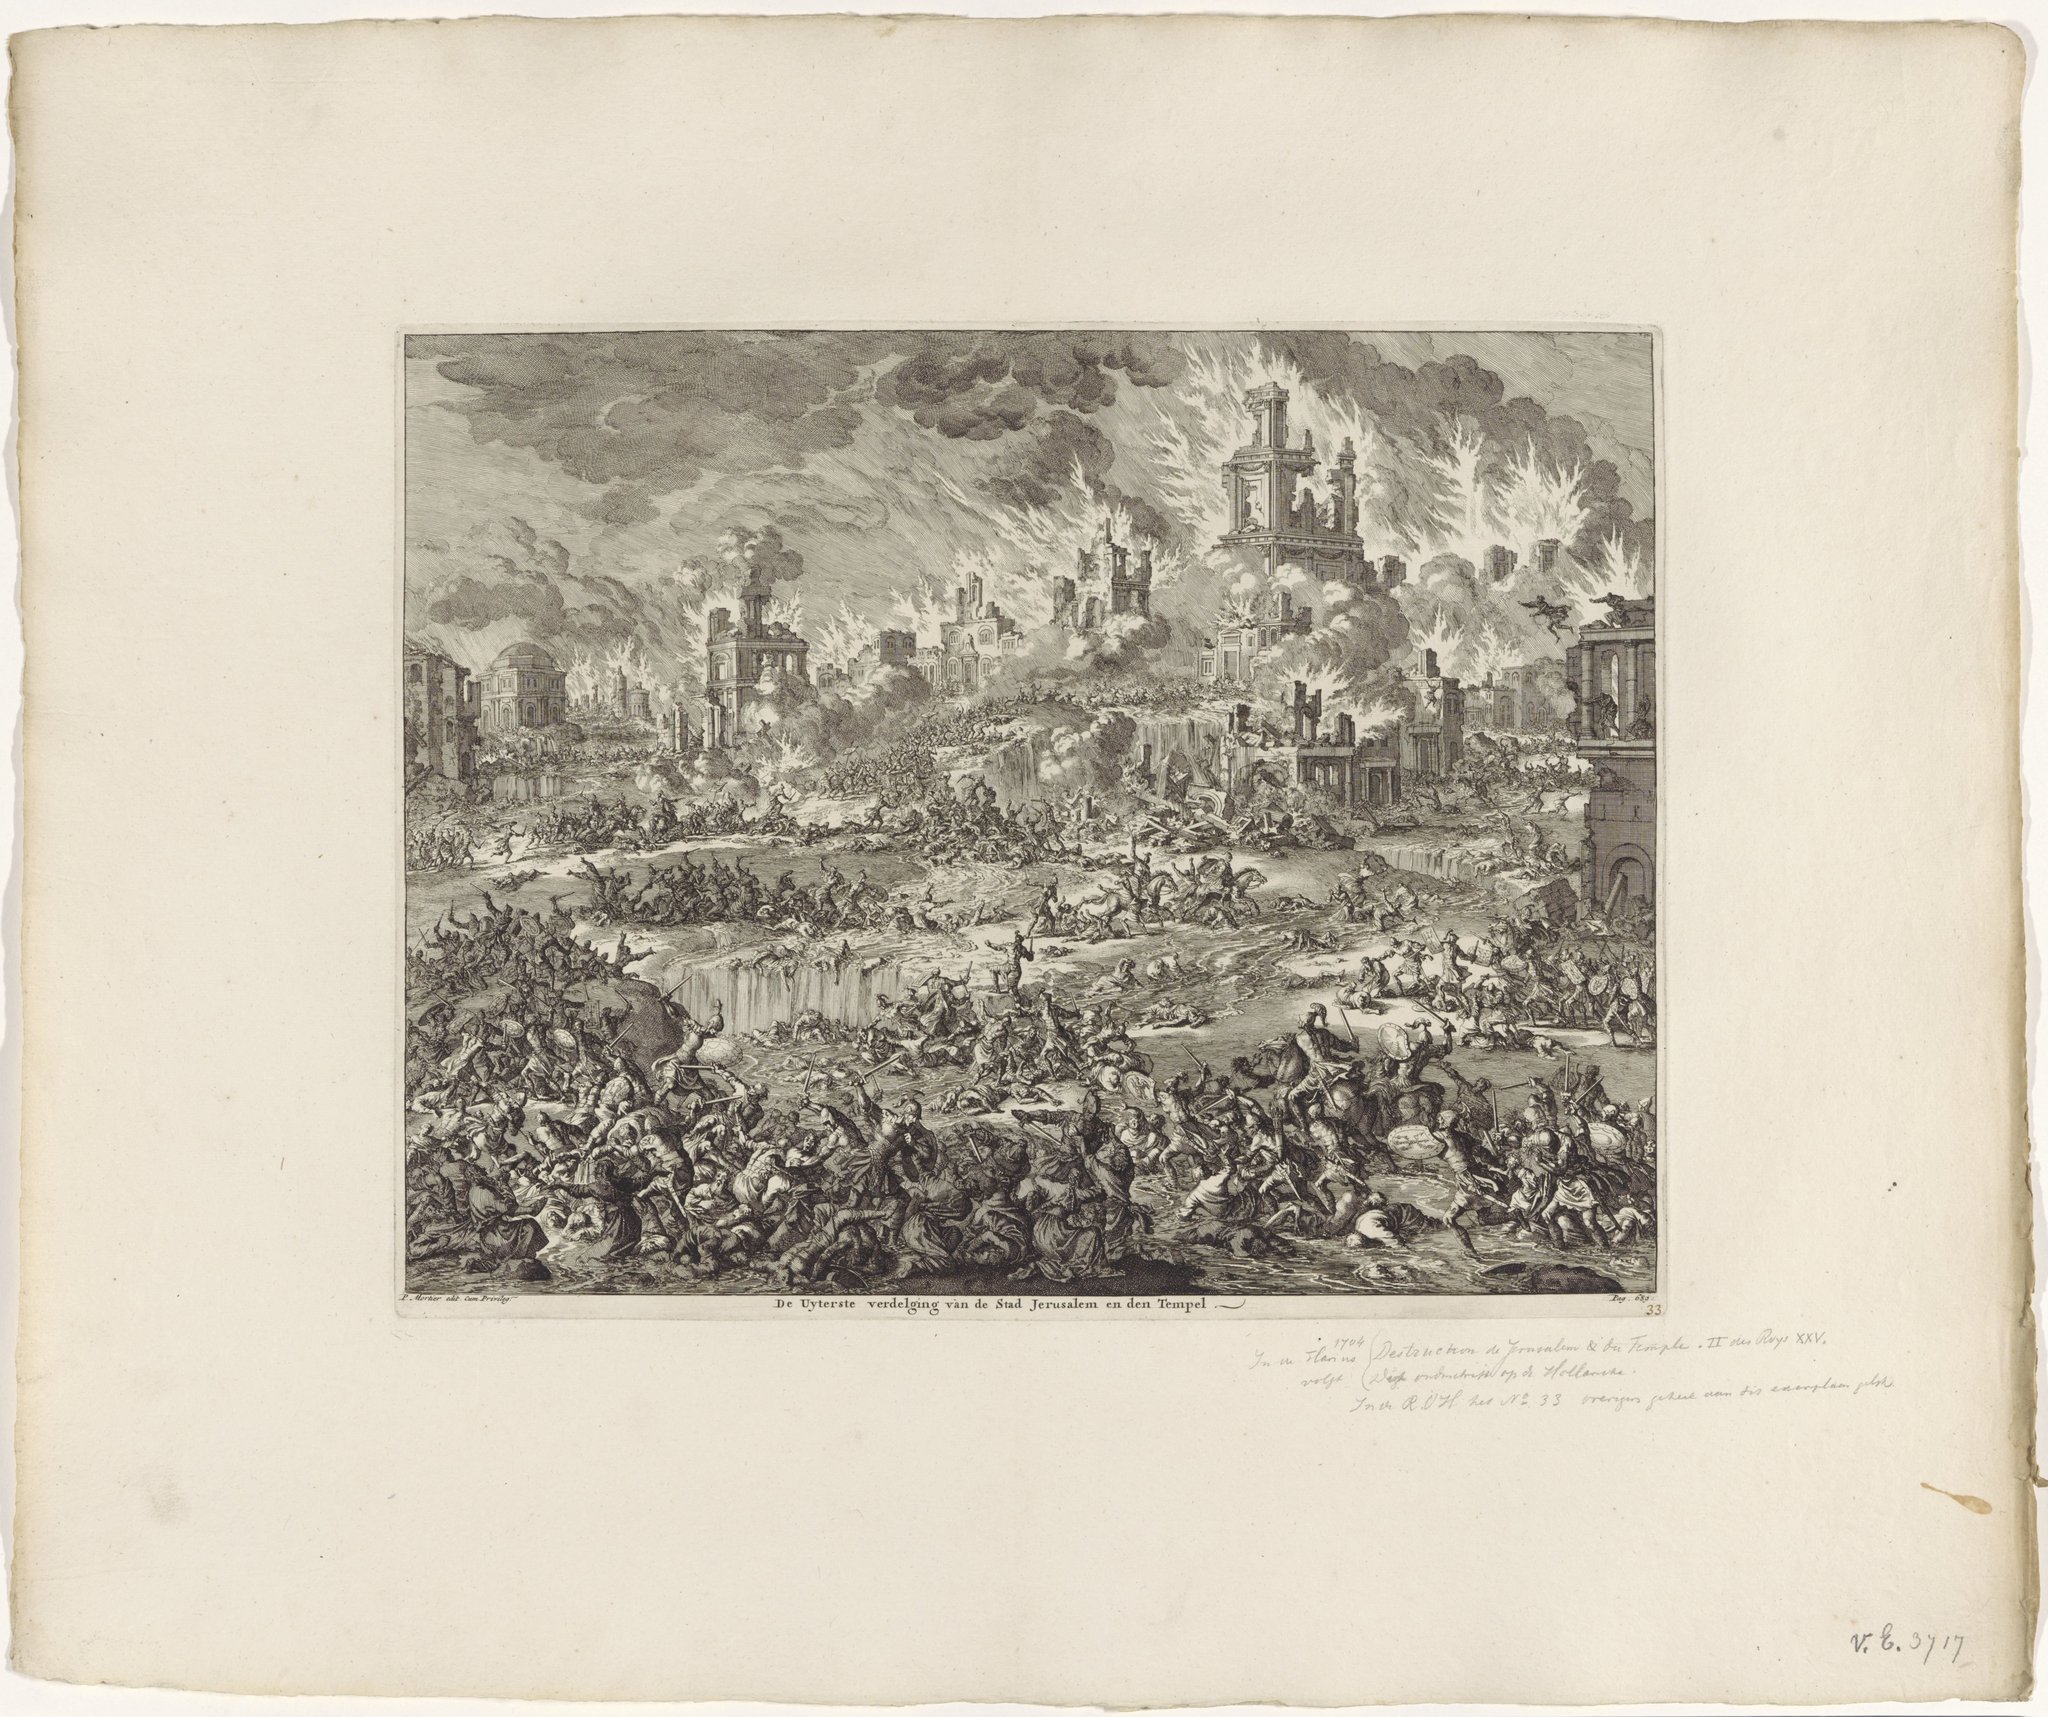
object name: print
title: De Uyterste verdelging van de Stad Jerusalem en den Tempel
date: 1708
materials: paper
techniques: etching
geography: amsterdam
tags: the people of judah, except the poorest, are taken to babylonia ~ story of zedekiah, nebuzaradan, commander of the babylonian army, burns down the temple and the palace of jerusalem ~ second siege of jerusalem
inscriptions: collector's mark: Lugt 2228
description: Na het beleg van Jeruzalem vertrekt het Babylonische leger terug naar huis met de geplunderde schatten van de stad. Op de achtergrond Jeruzalem in de vlammen.